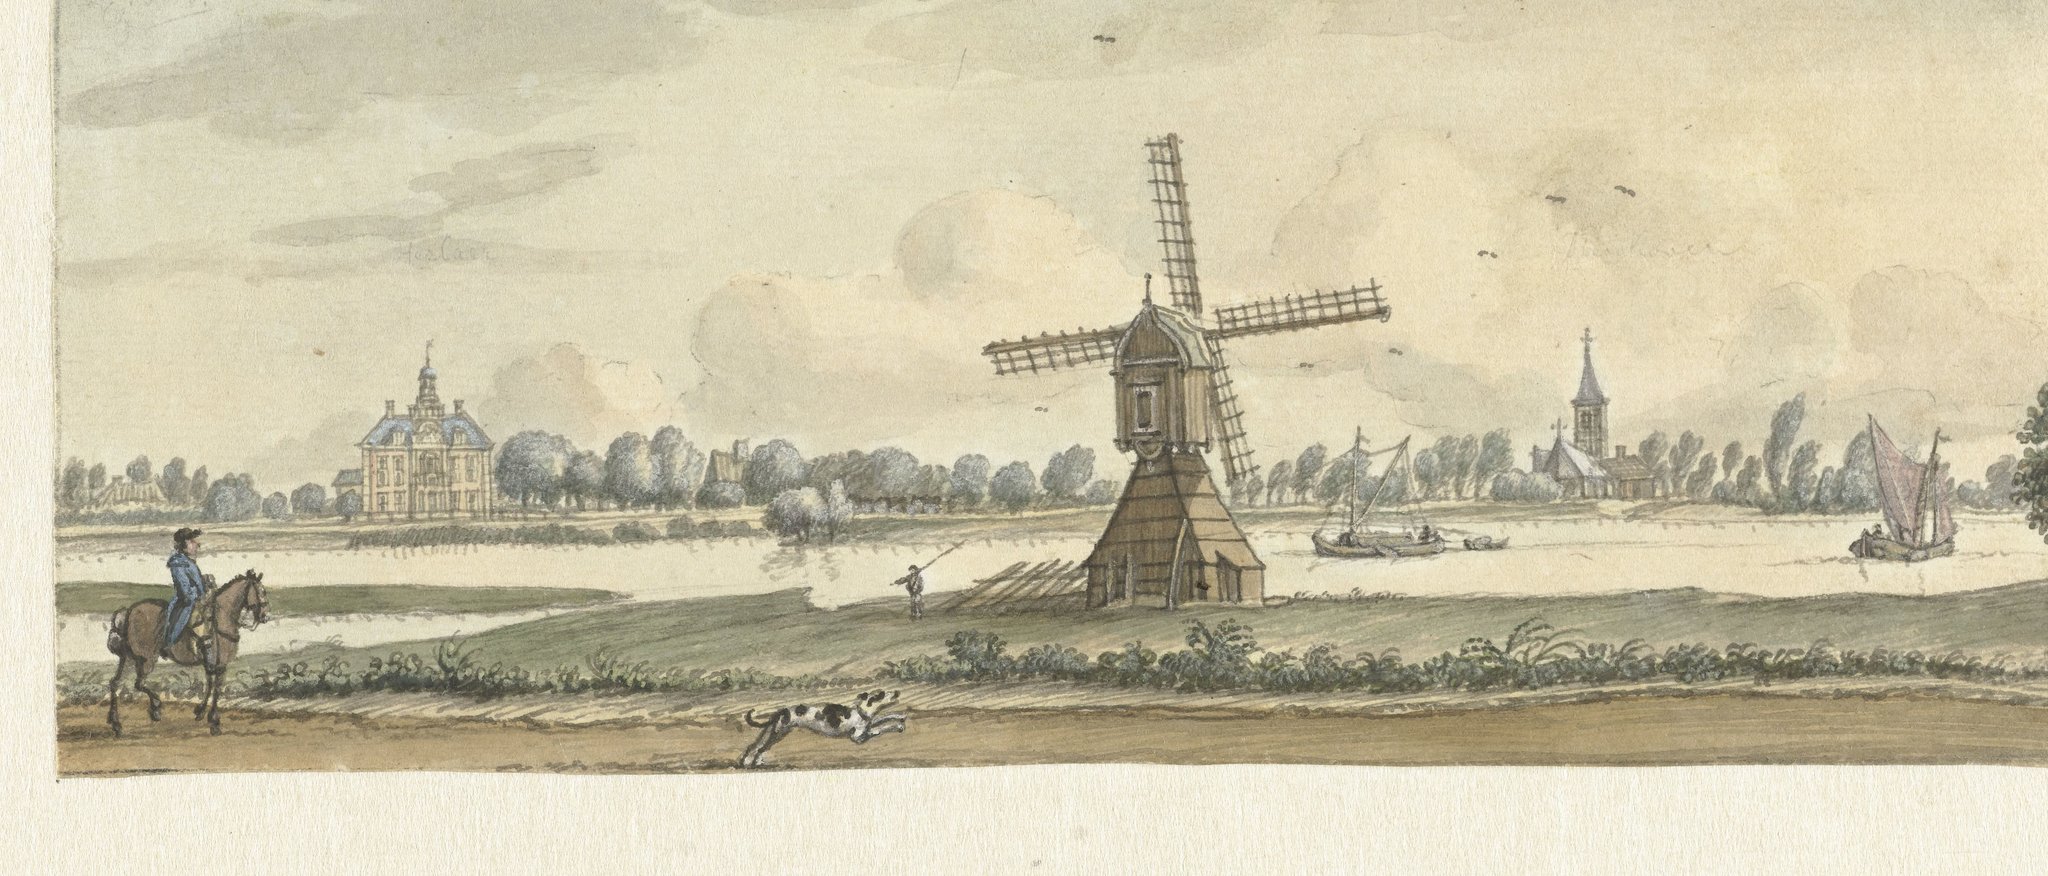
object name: watercolor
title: Gezicht op Tienhoven en het huis Herlaar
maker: jan de beijer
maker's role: draughtsman, print maker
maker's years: 1703-1780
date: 1750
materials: paint, ink, paper, watercolor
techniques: brush, pen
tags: castle, prospect of city, town panorama, silhouette of city